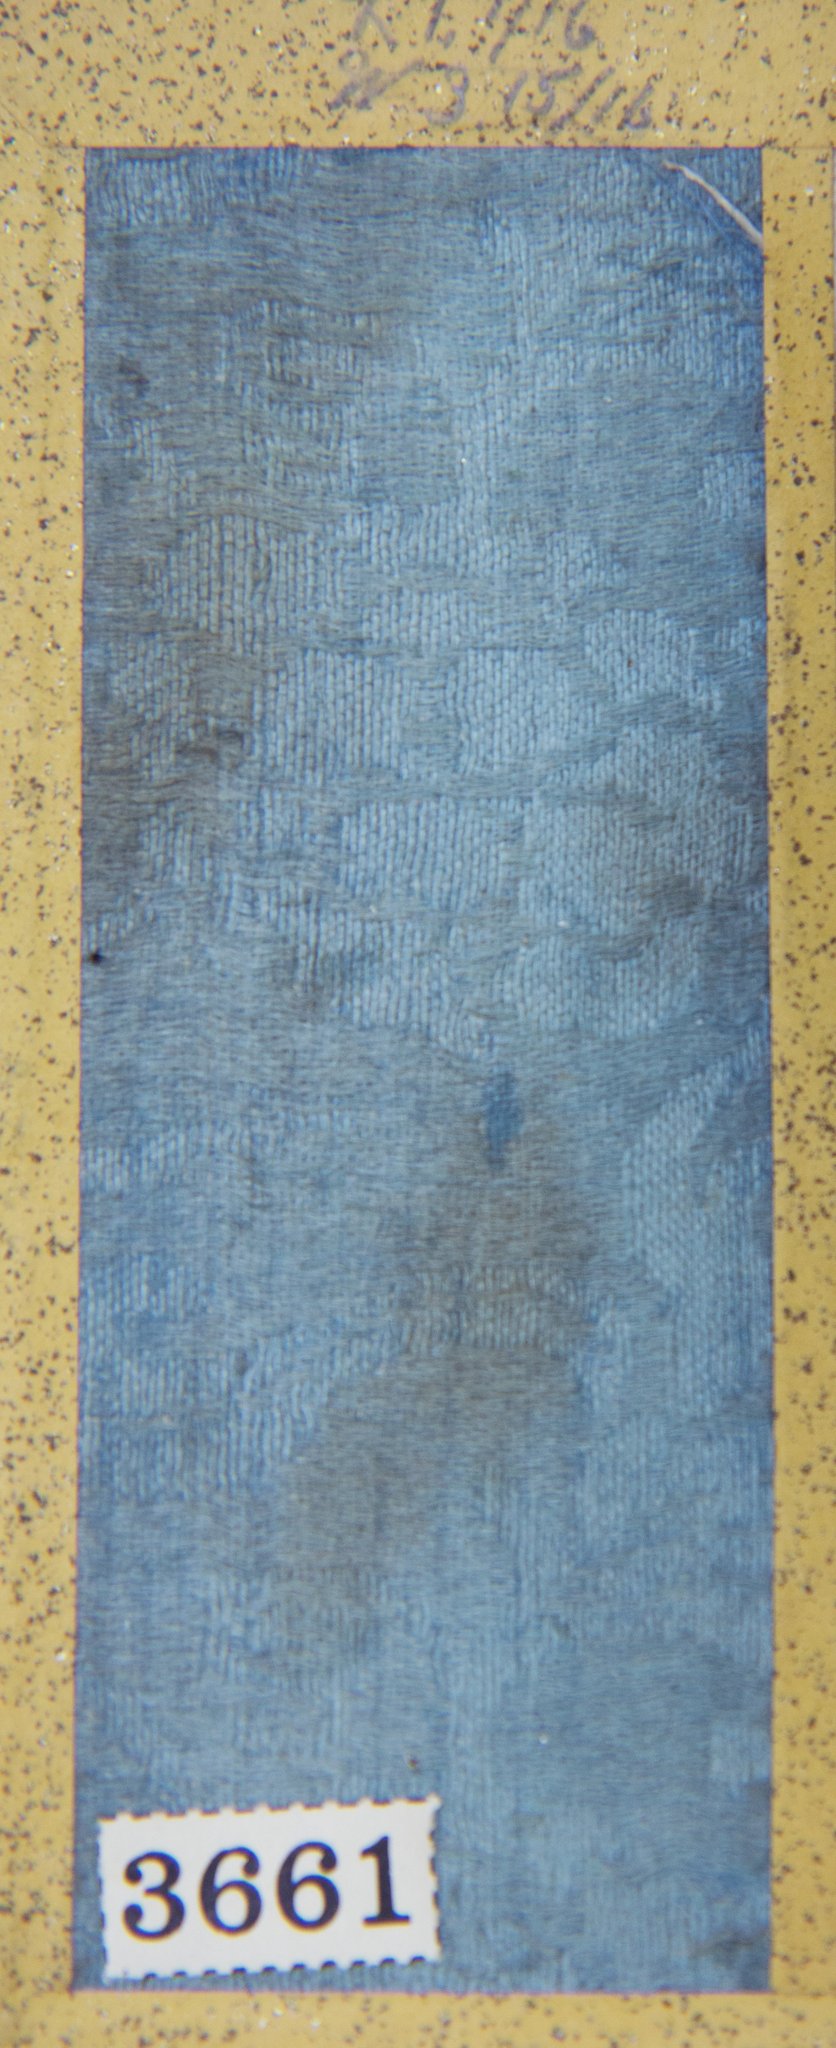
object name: sample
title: Textile Sample from Sample Book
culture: japanese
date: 1801-1900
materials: silk